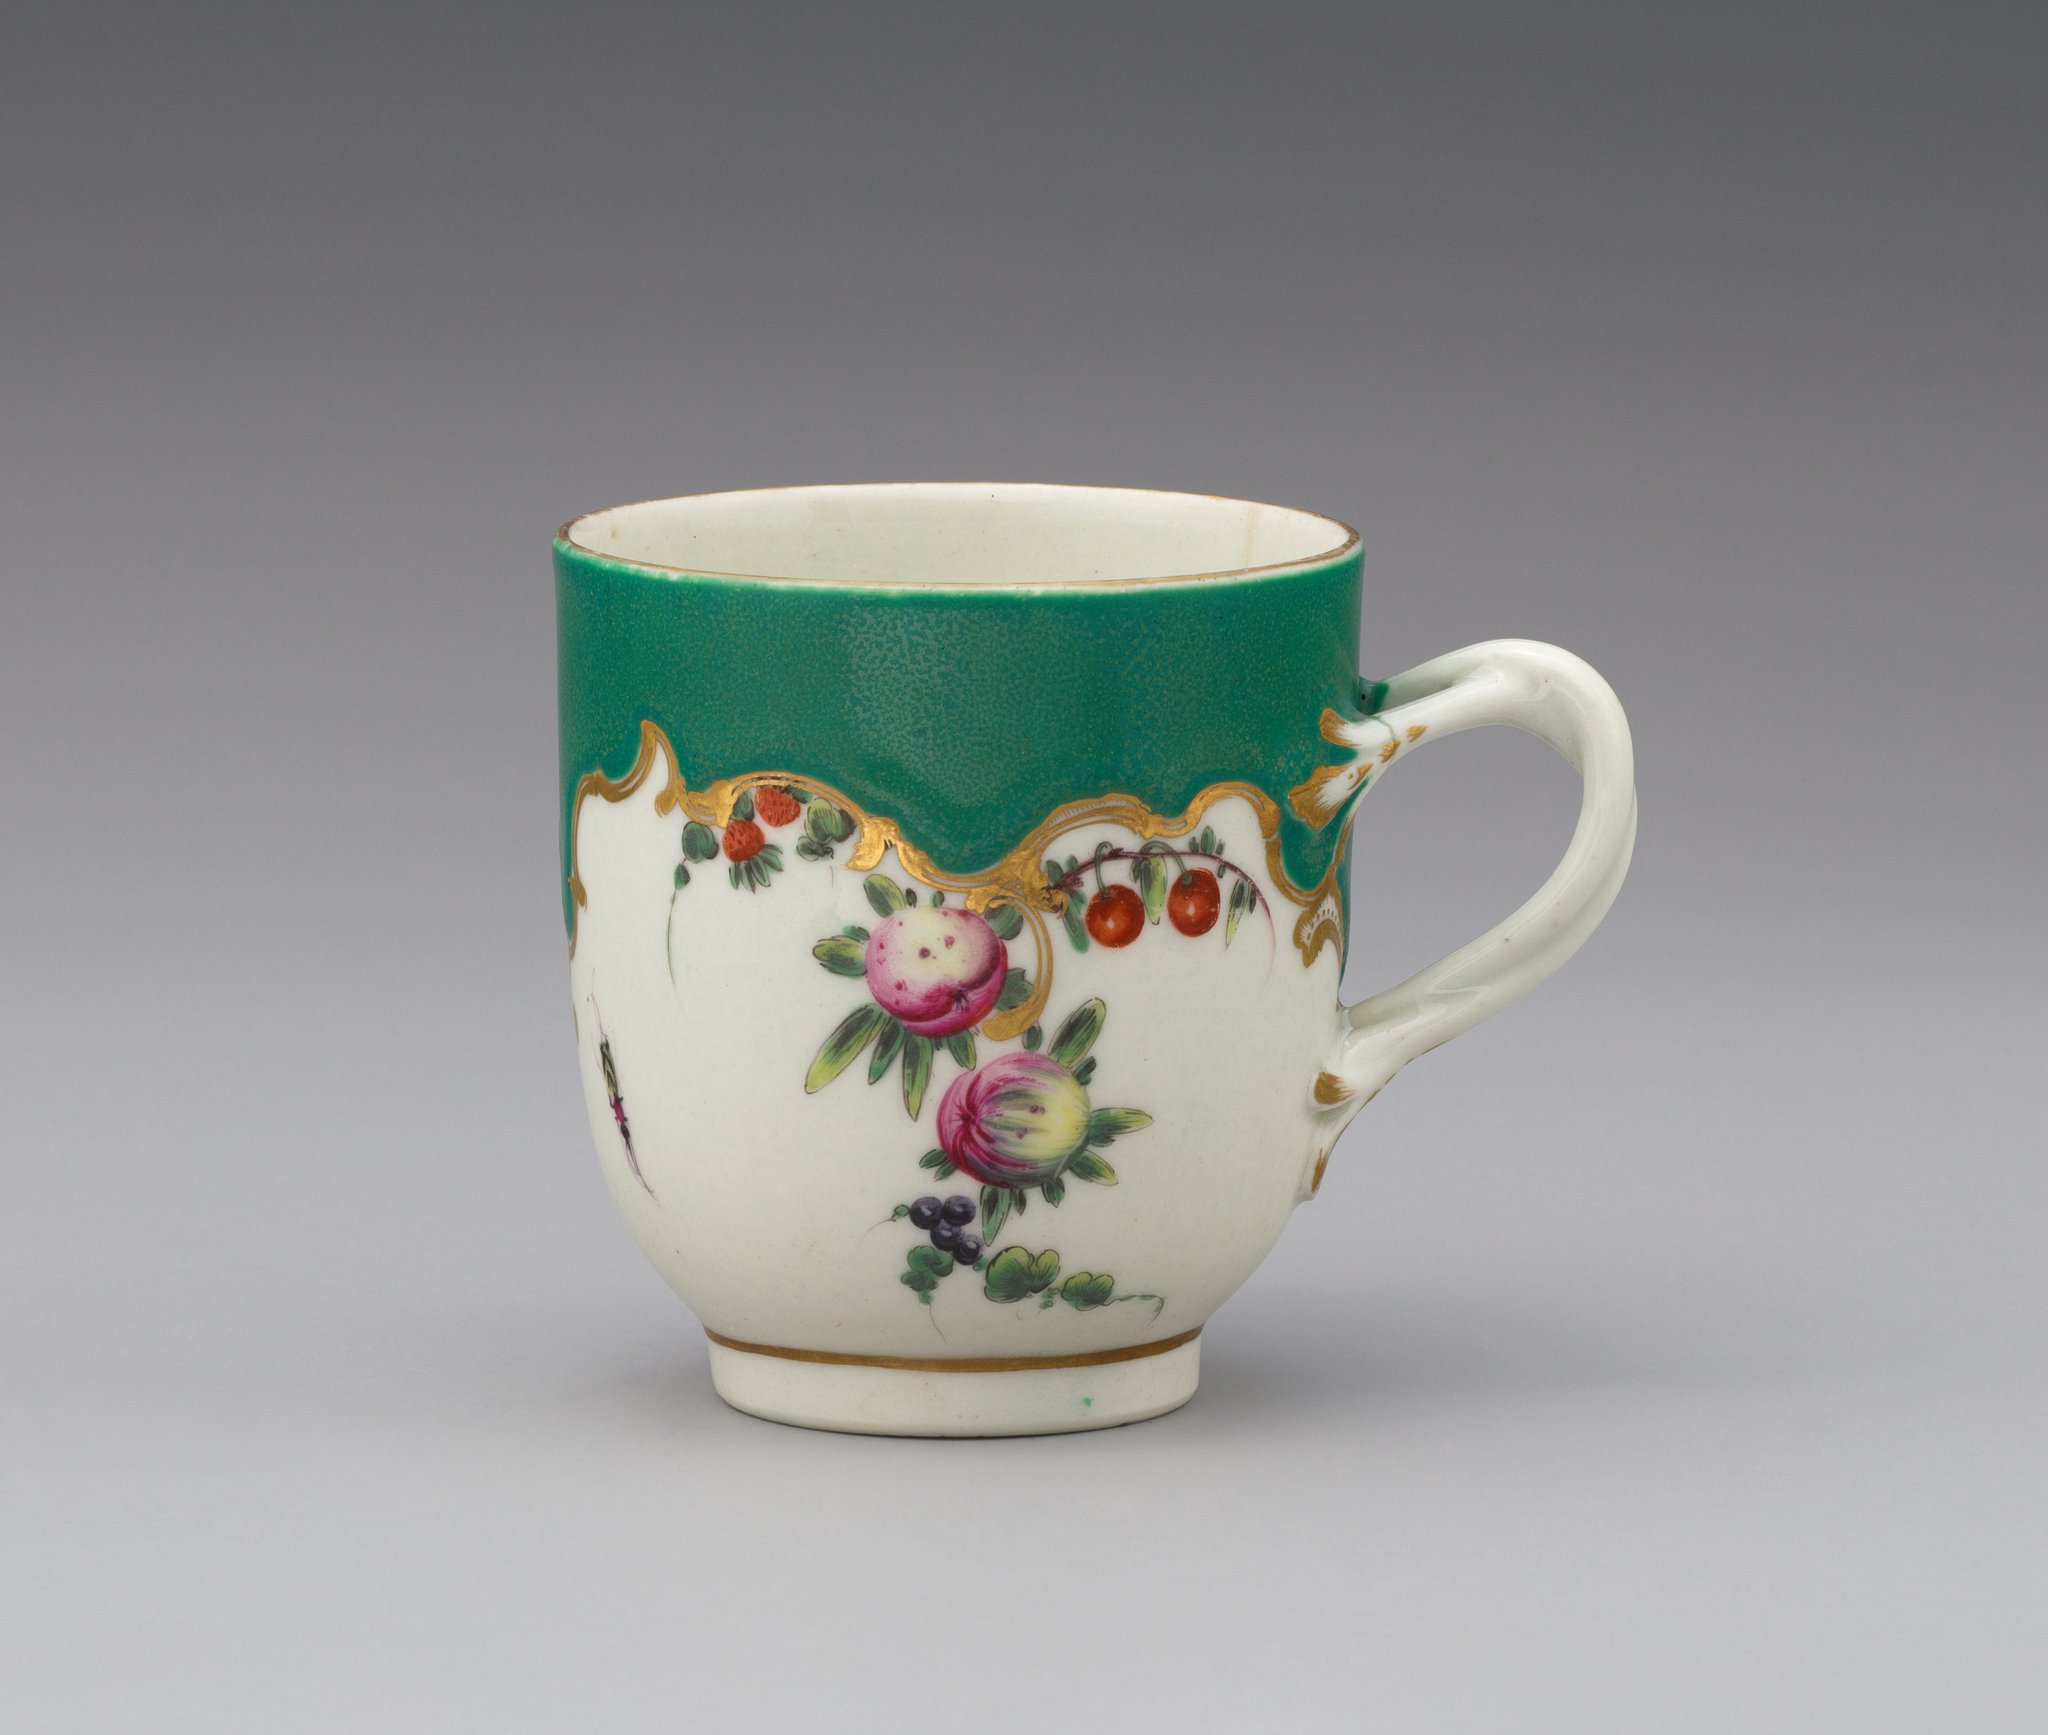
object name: cup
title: Cup (part of a service)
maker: worcester factory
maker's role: factory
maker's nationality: british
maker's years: 1751-2008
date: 1770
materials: soft paste porcelain